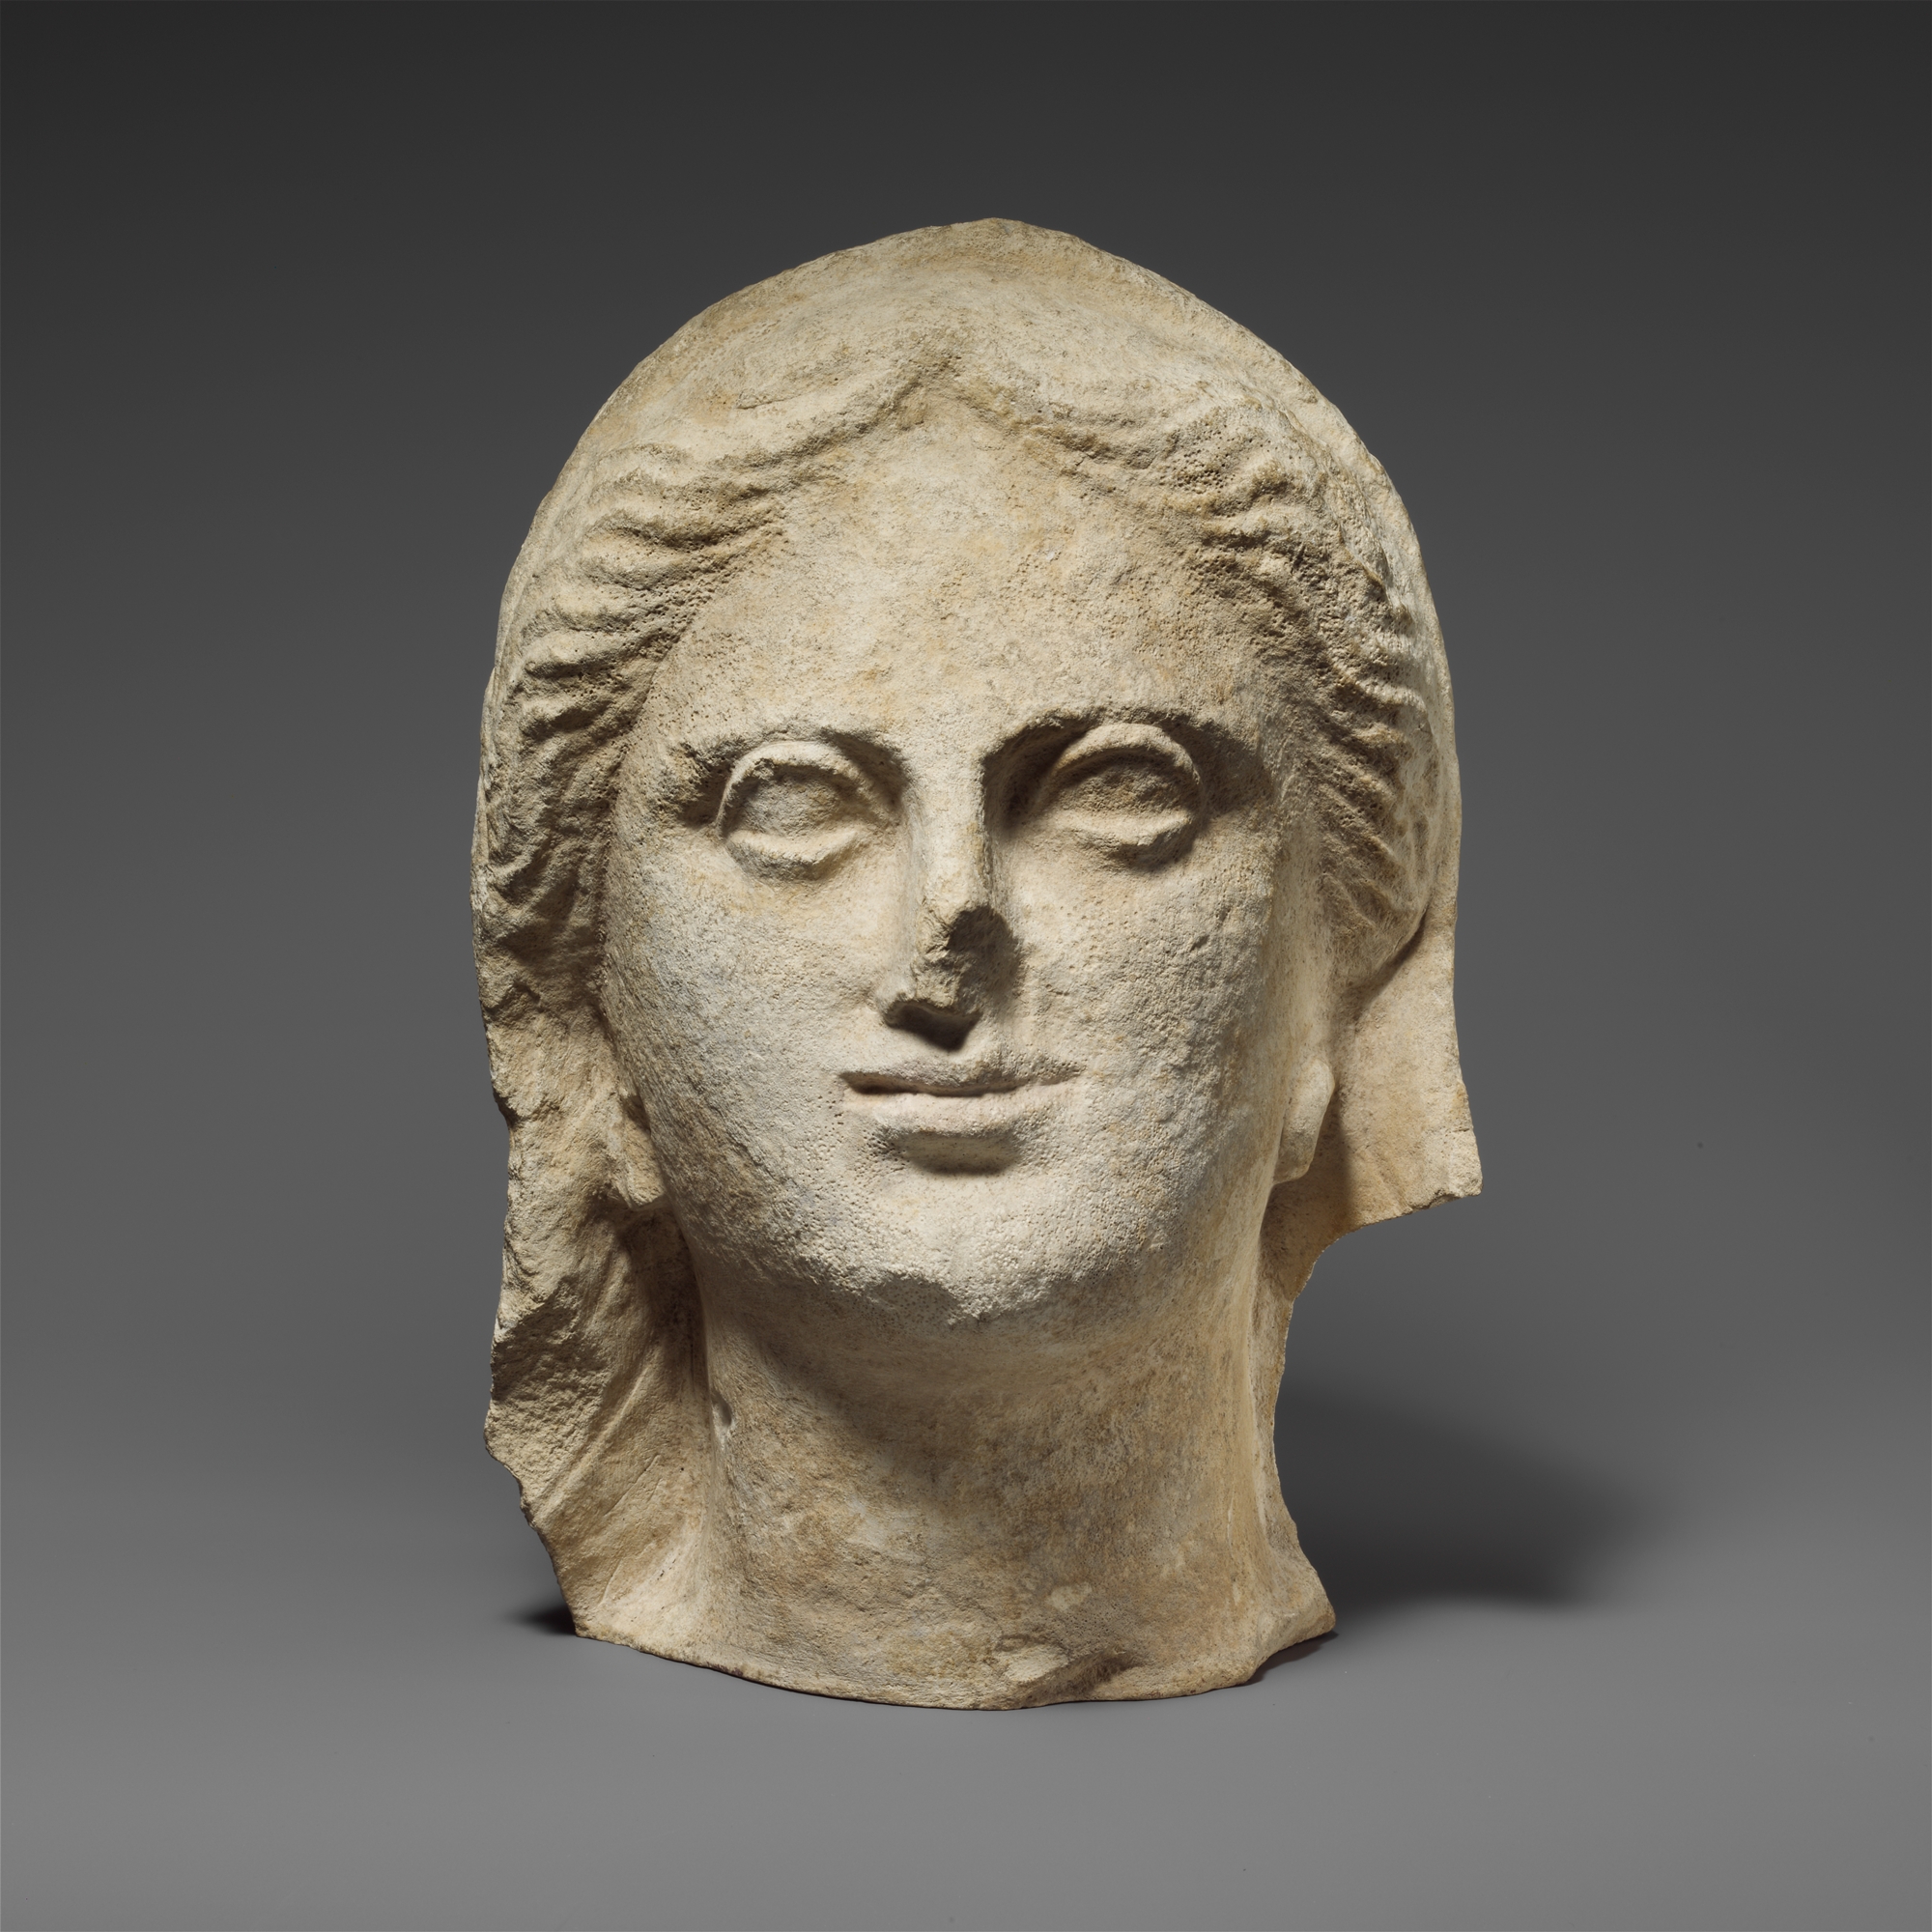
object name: head of a woman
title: Limestone head of a veiled female votary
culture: cypriot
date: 400-1 BCE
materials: limestone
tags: heads,women